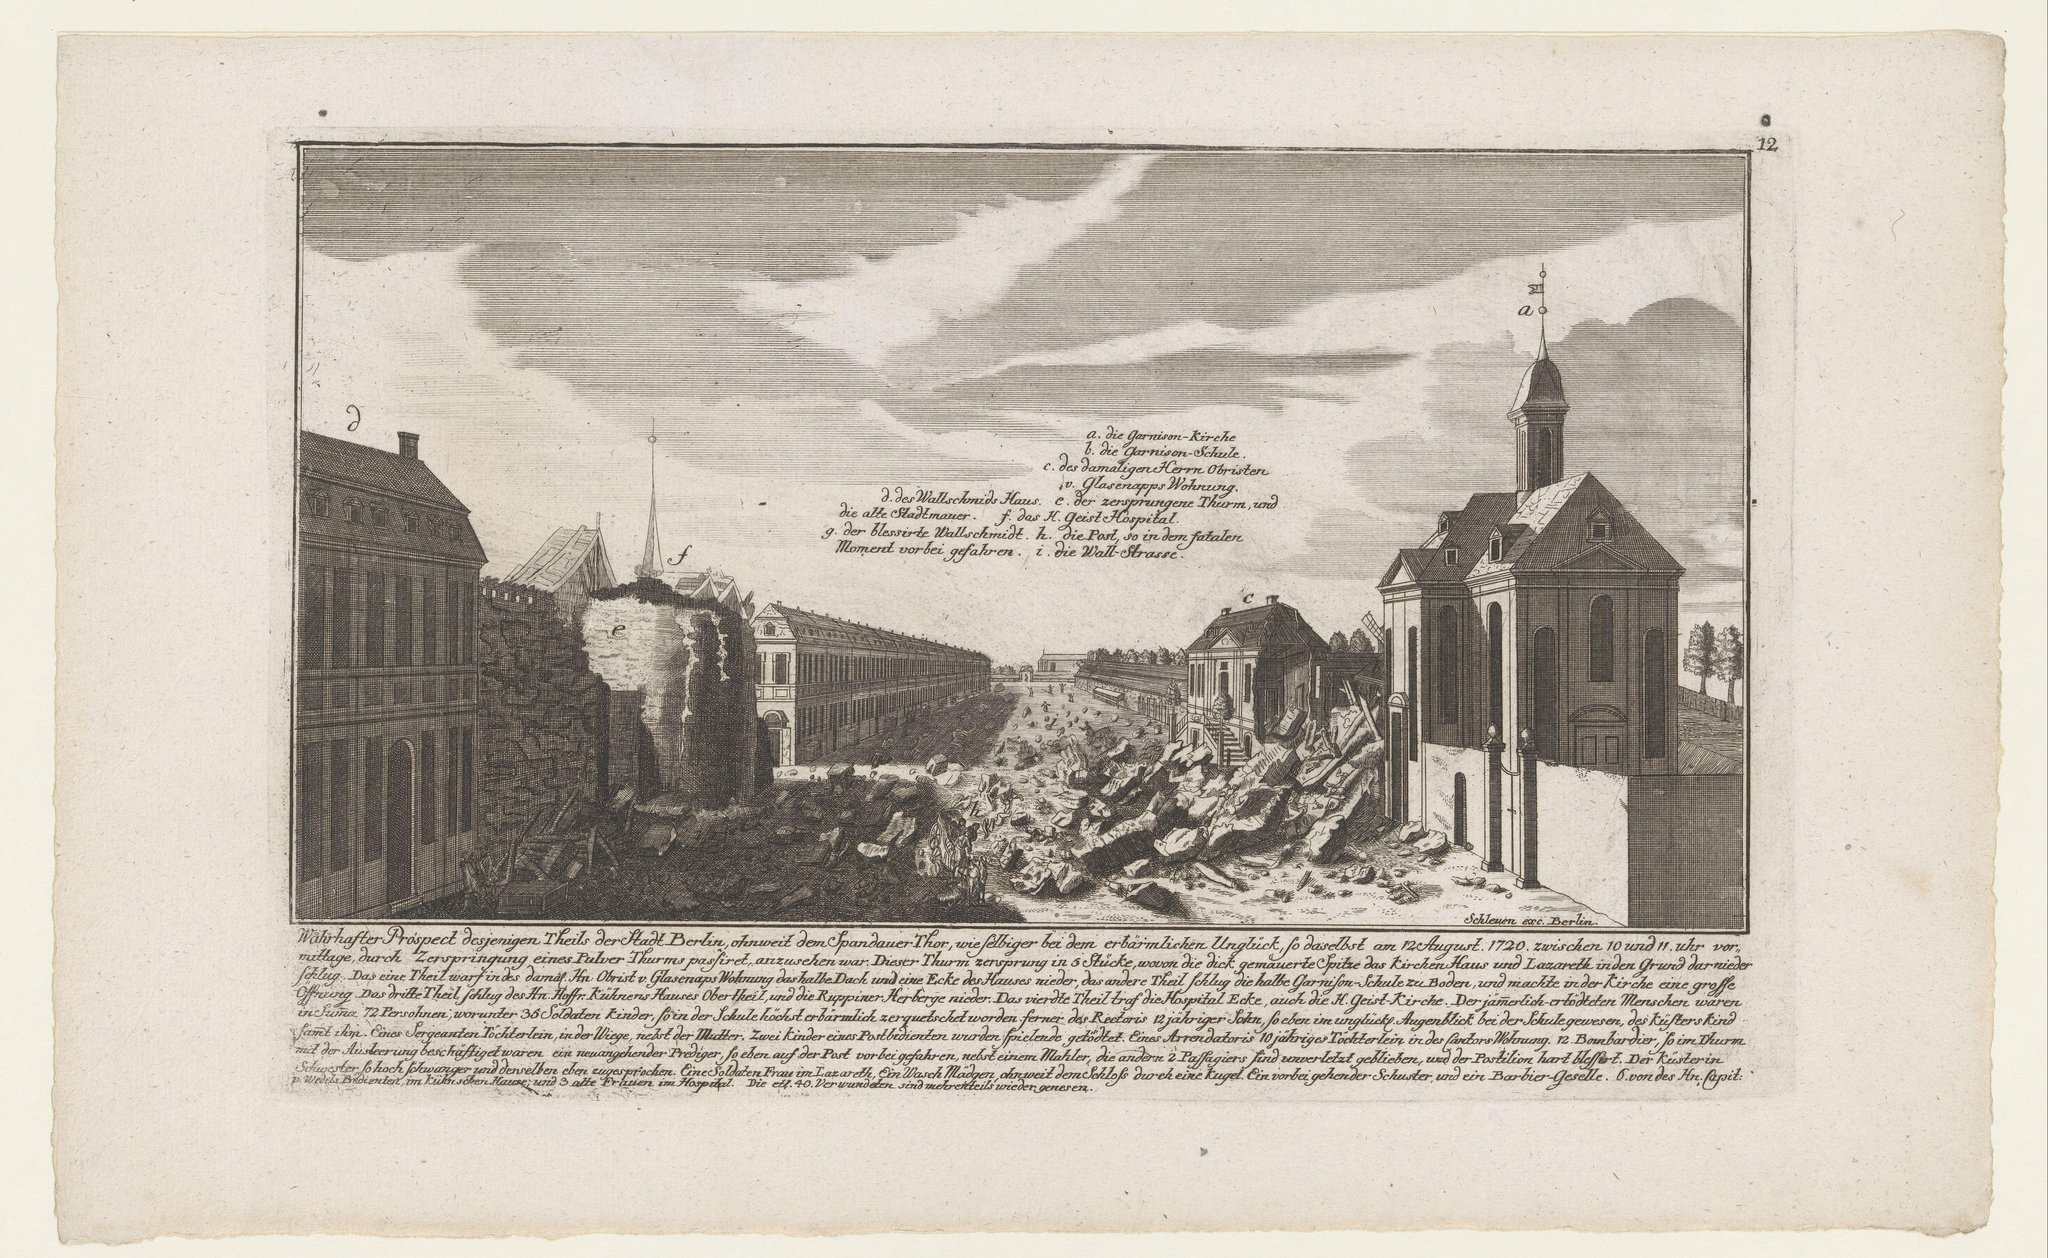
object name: print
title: De ontploffing van de kruittoren aan de Wallstrasse, te Berlijn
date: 1740-1774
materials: paper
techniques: engraving, etching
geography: berlin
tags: church (exterior), gunpowder disaster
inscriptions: collector's mark: Lugt 2228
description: De ontploffing van de kruittoren aan de Wallstrasse, tegenwoordig de Zillestrasse, te Berlijn. Rechts de Garnisonkirche. Rechtsboven genummerd: 12.